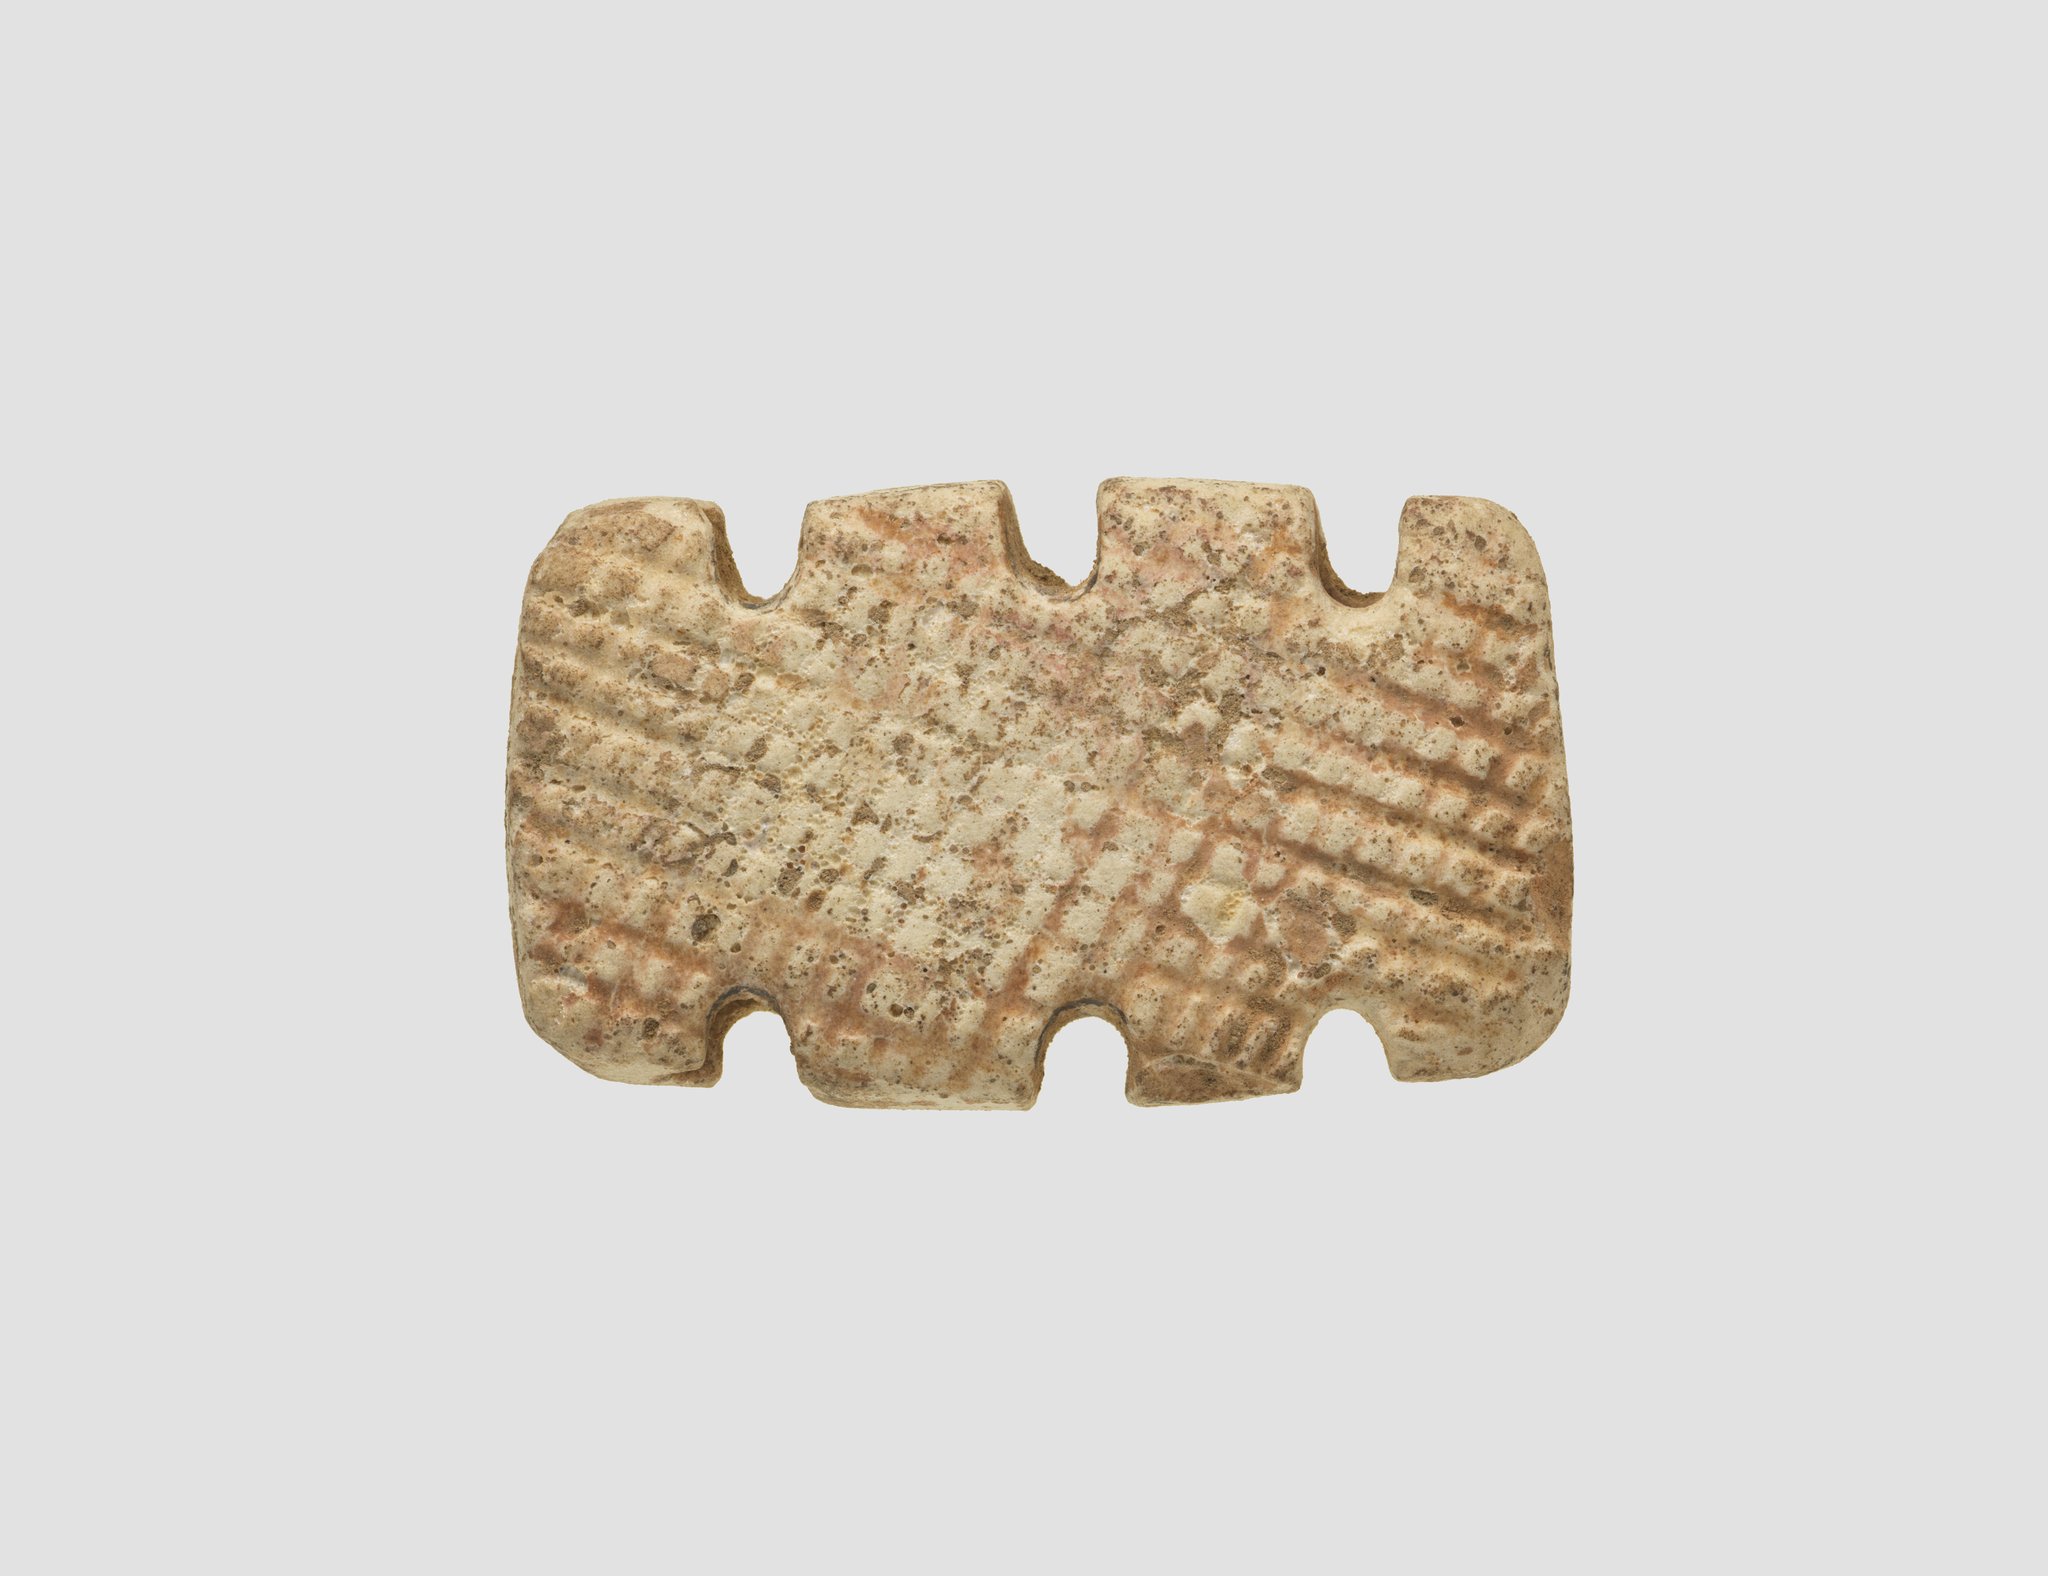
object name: bead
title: Beads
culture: iranian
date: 900-801 BCE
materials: faience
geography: iran